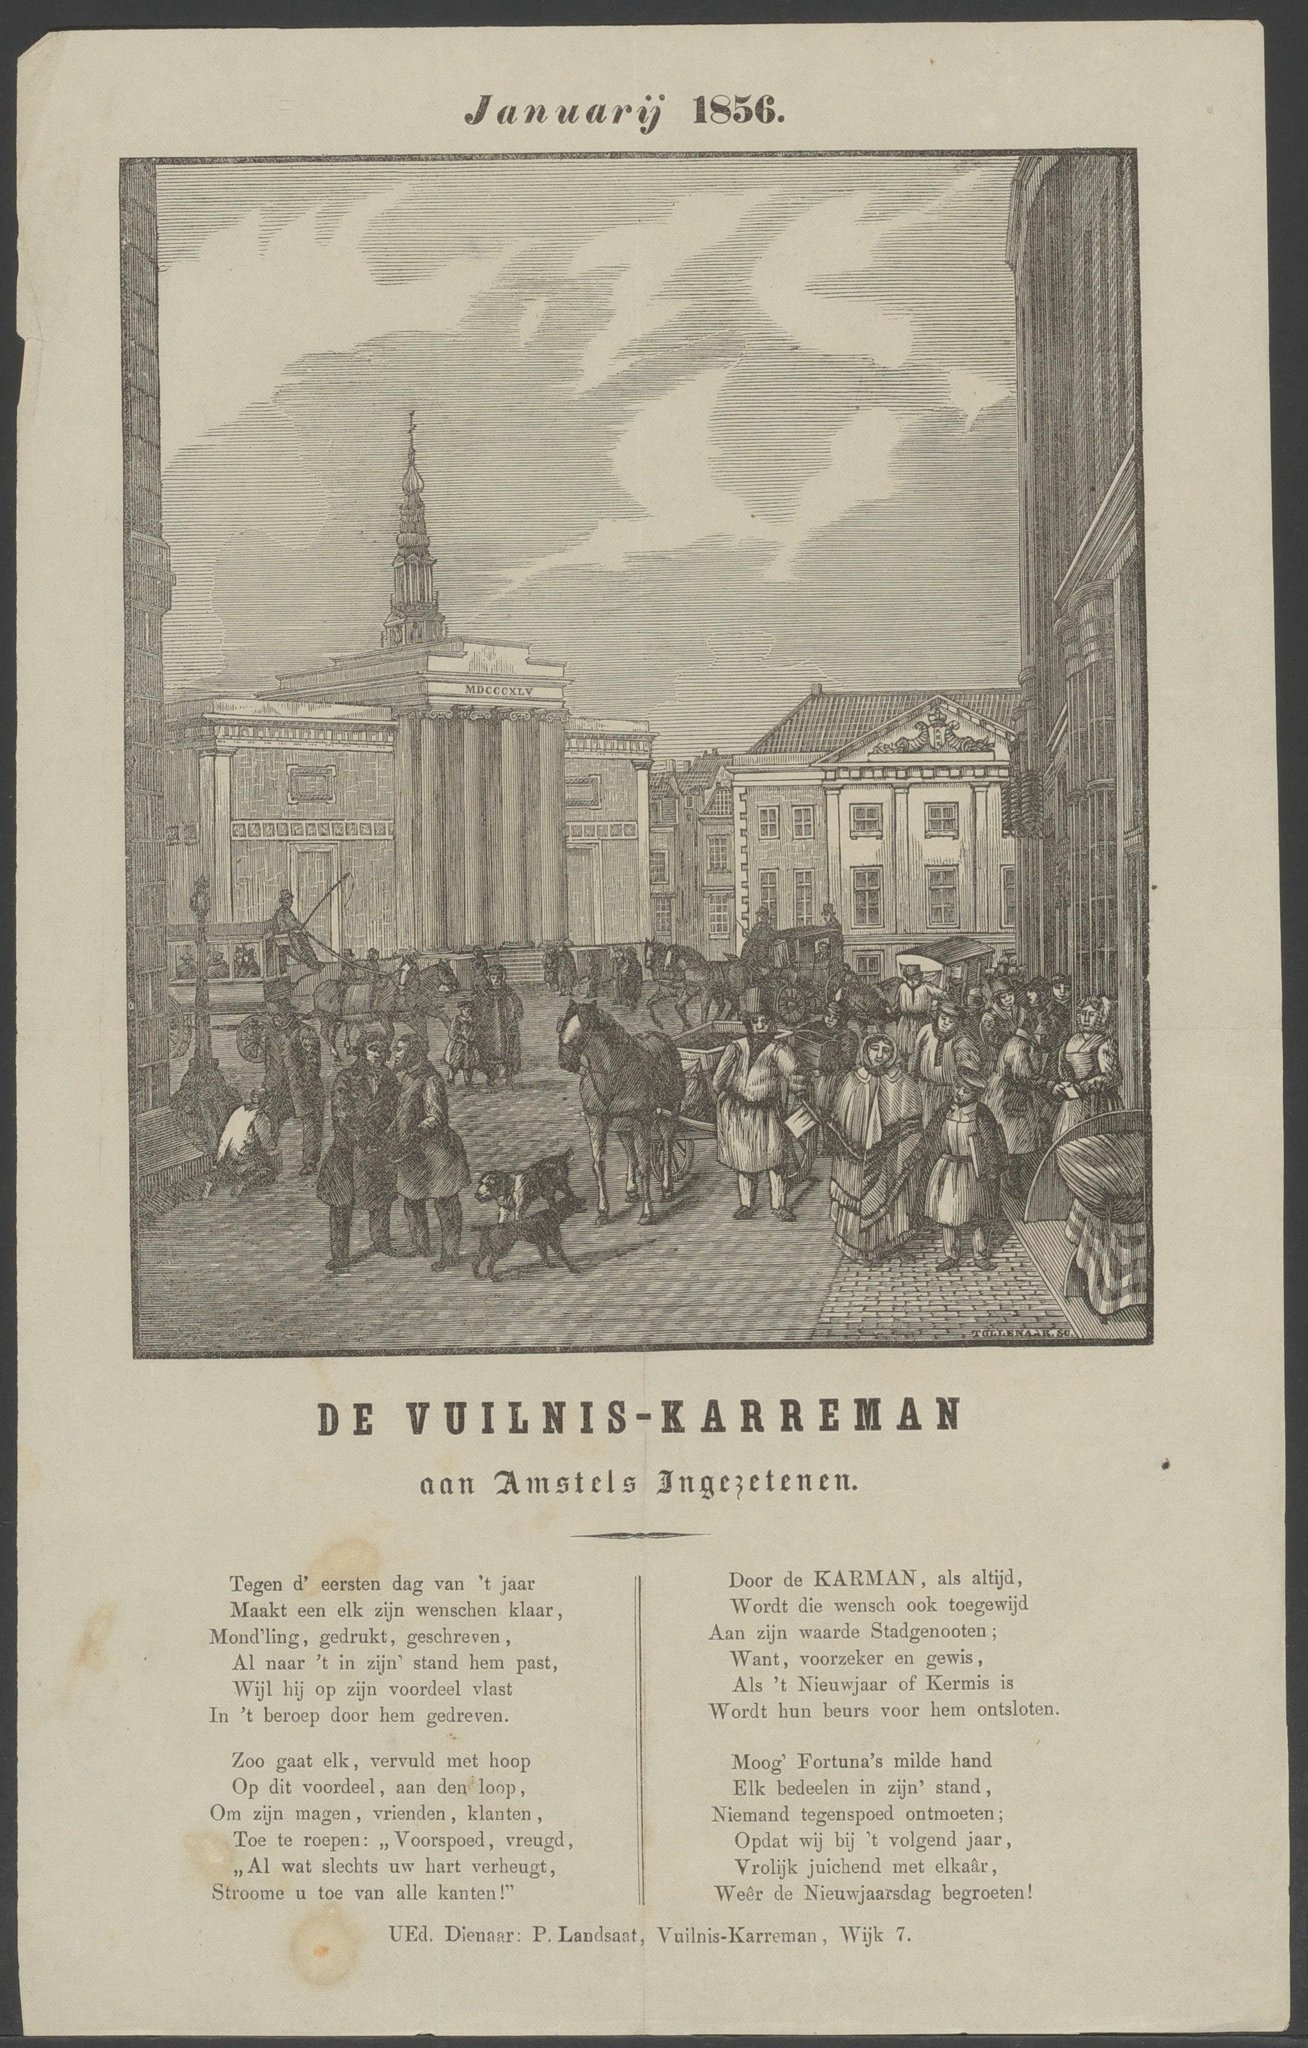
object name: new year card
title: Nieuwjaarswens van de vuilnismannen van Amsterdam voor het jaar 1856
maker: dirk wijbrand tollenaar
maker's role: print maker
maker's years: 1808-1858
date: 1855-1856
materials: paper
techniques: letterpress printing, engraving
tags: street, garbage collection, amsterdam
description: Nieuwjaarswens van de Amsterdamse vuilnismannen voor het jaar 1856. Gezicht op de Dam met de Beurs van Zocher en het Commandantshuis te Amsterdam. Tussen het publiek de vuilnismannen met hun kar. Met gedicht in twee kolommen. Van de vuilniskarman in de wijk no. 7: P. Landsant. Onderwerpsrubrieken binnen de Atlas Zeden en Gewoonten: Zeden en gewoonten in engeren zin, Volksleven, Volksbladen, Nieuwjaars- en Kerstwenschen, Amsterdam.